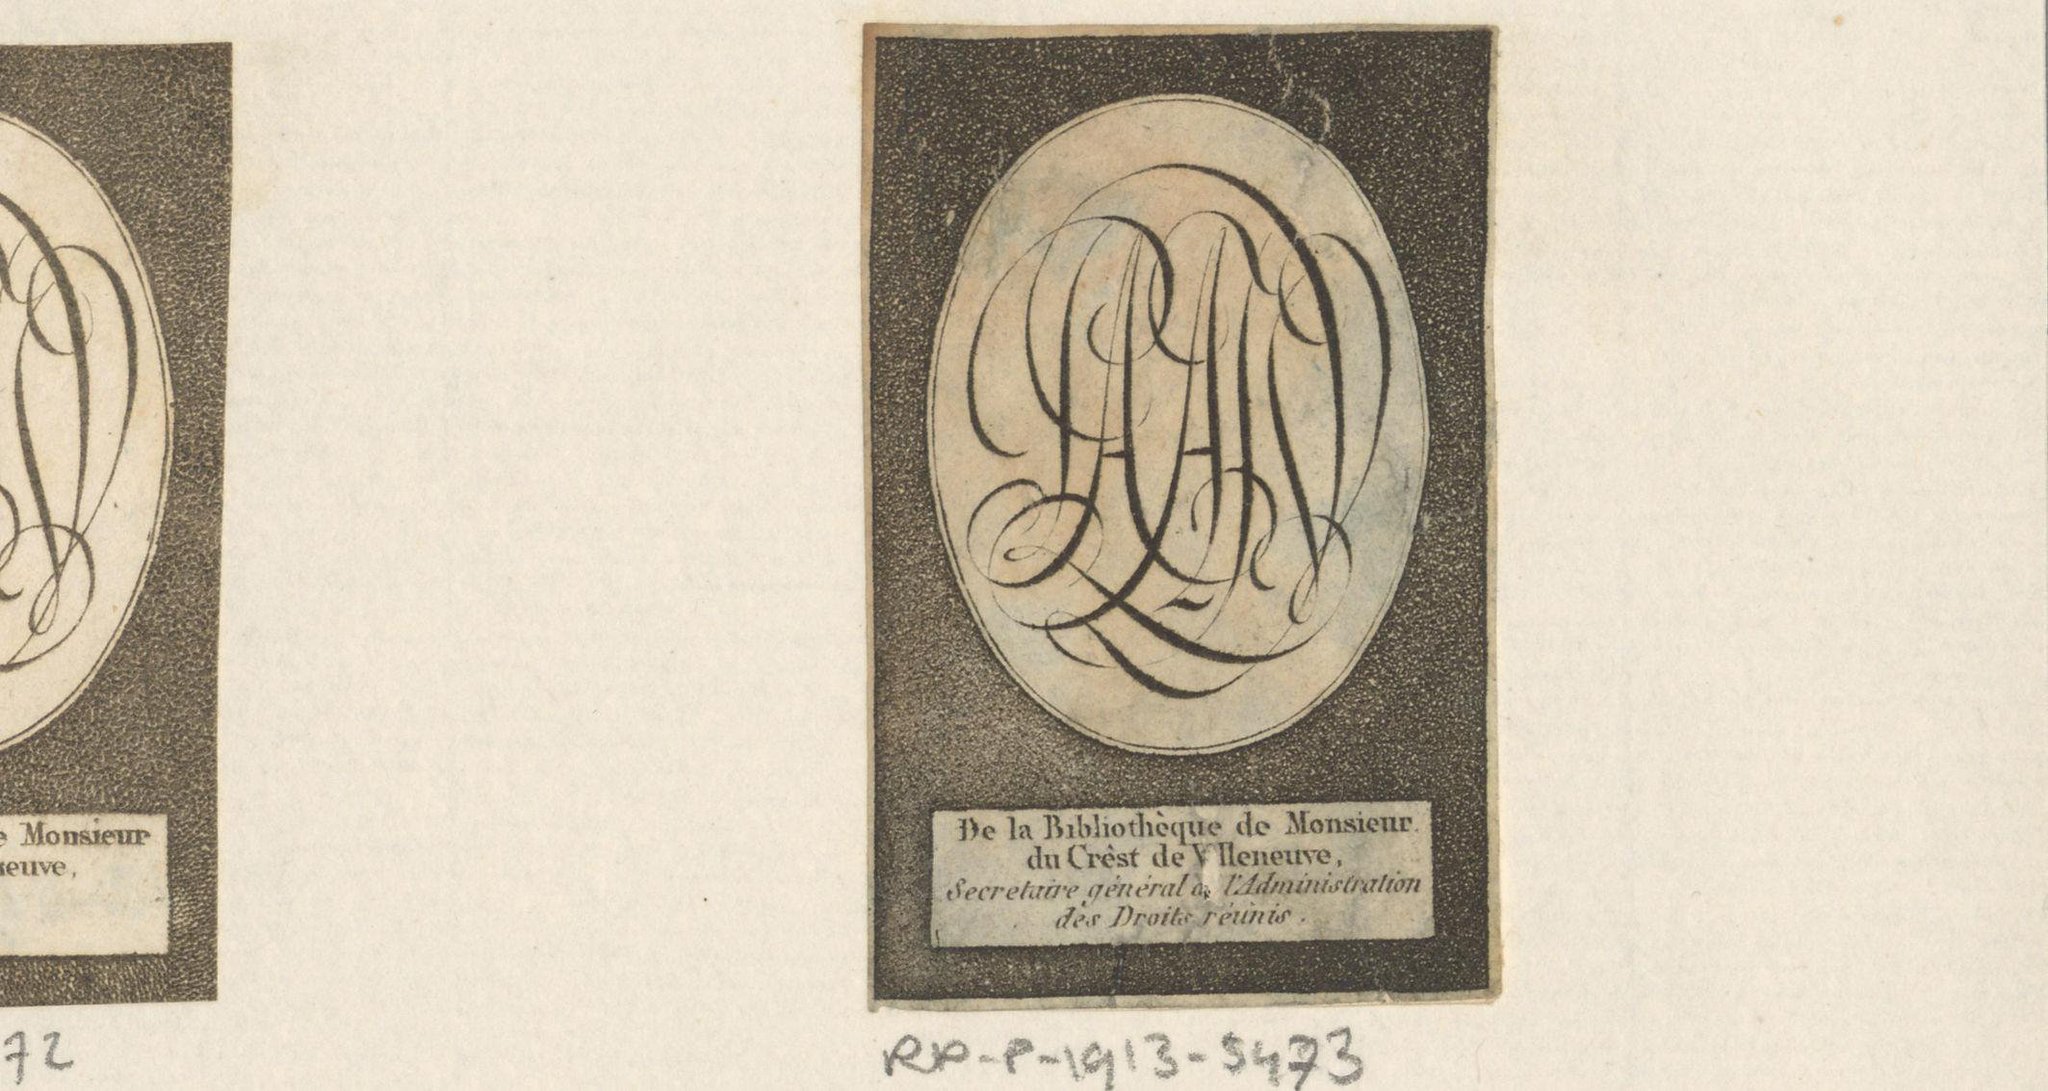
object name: bookplate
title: De la bibliothèque de monsieur Du Crest de Villeneuve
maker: Anonymous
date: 1750-1899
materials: paper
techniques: etching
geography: france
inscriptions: collector's mark: Lugt 2760, collector's mark: Lugt 2233